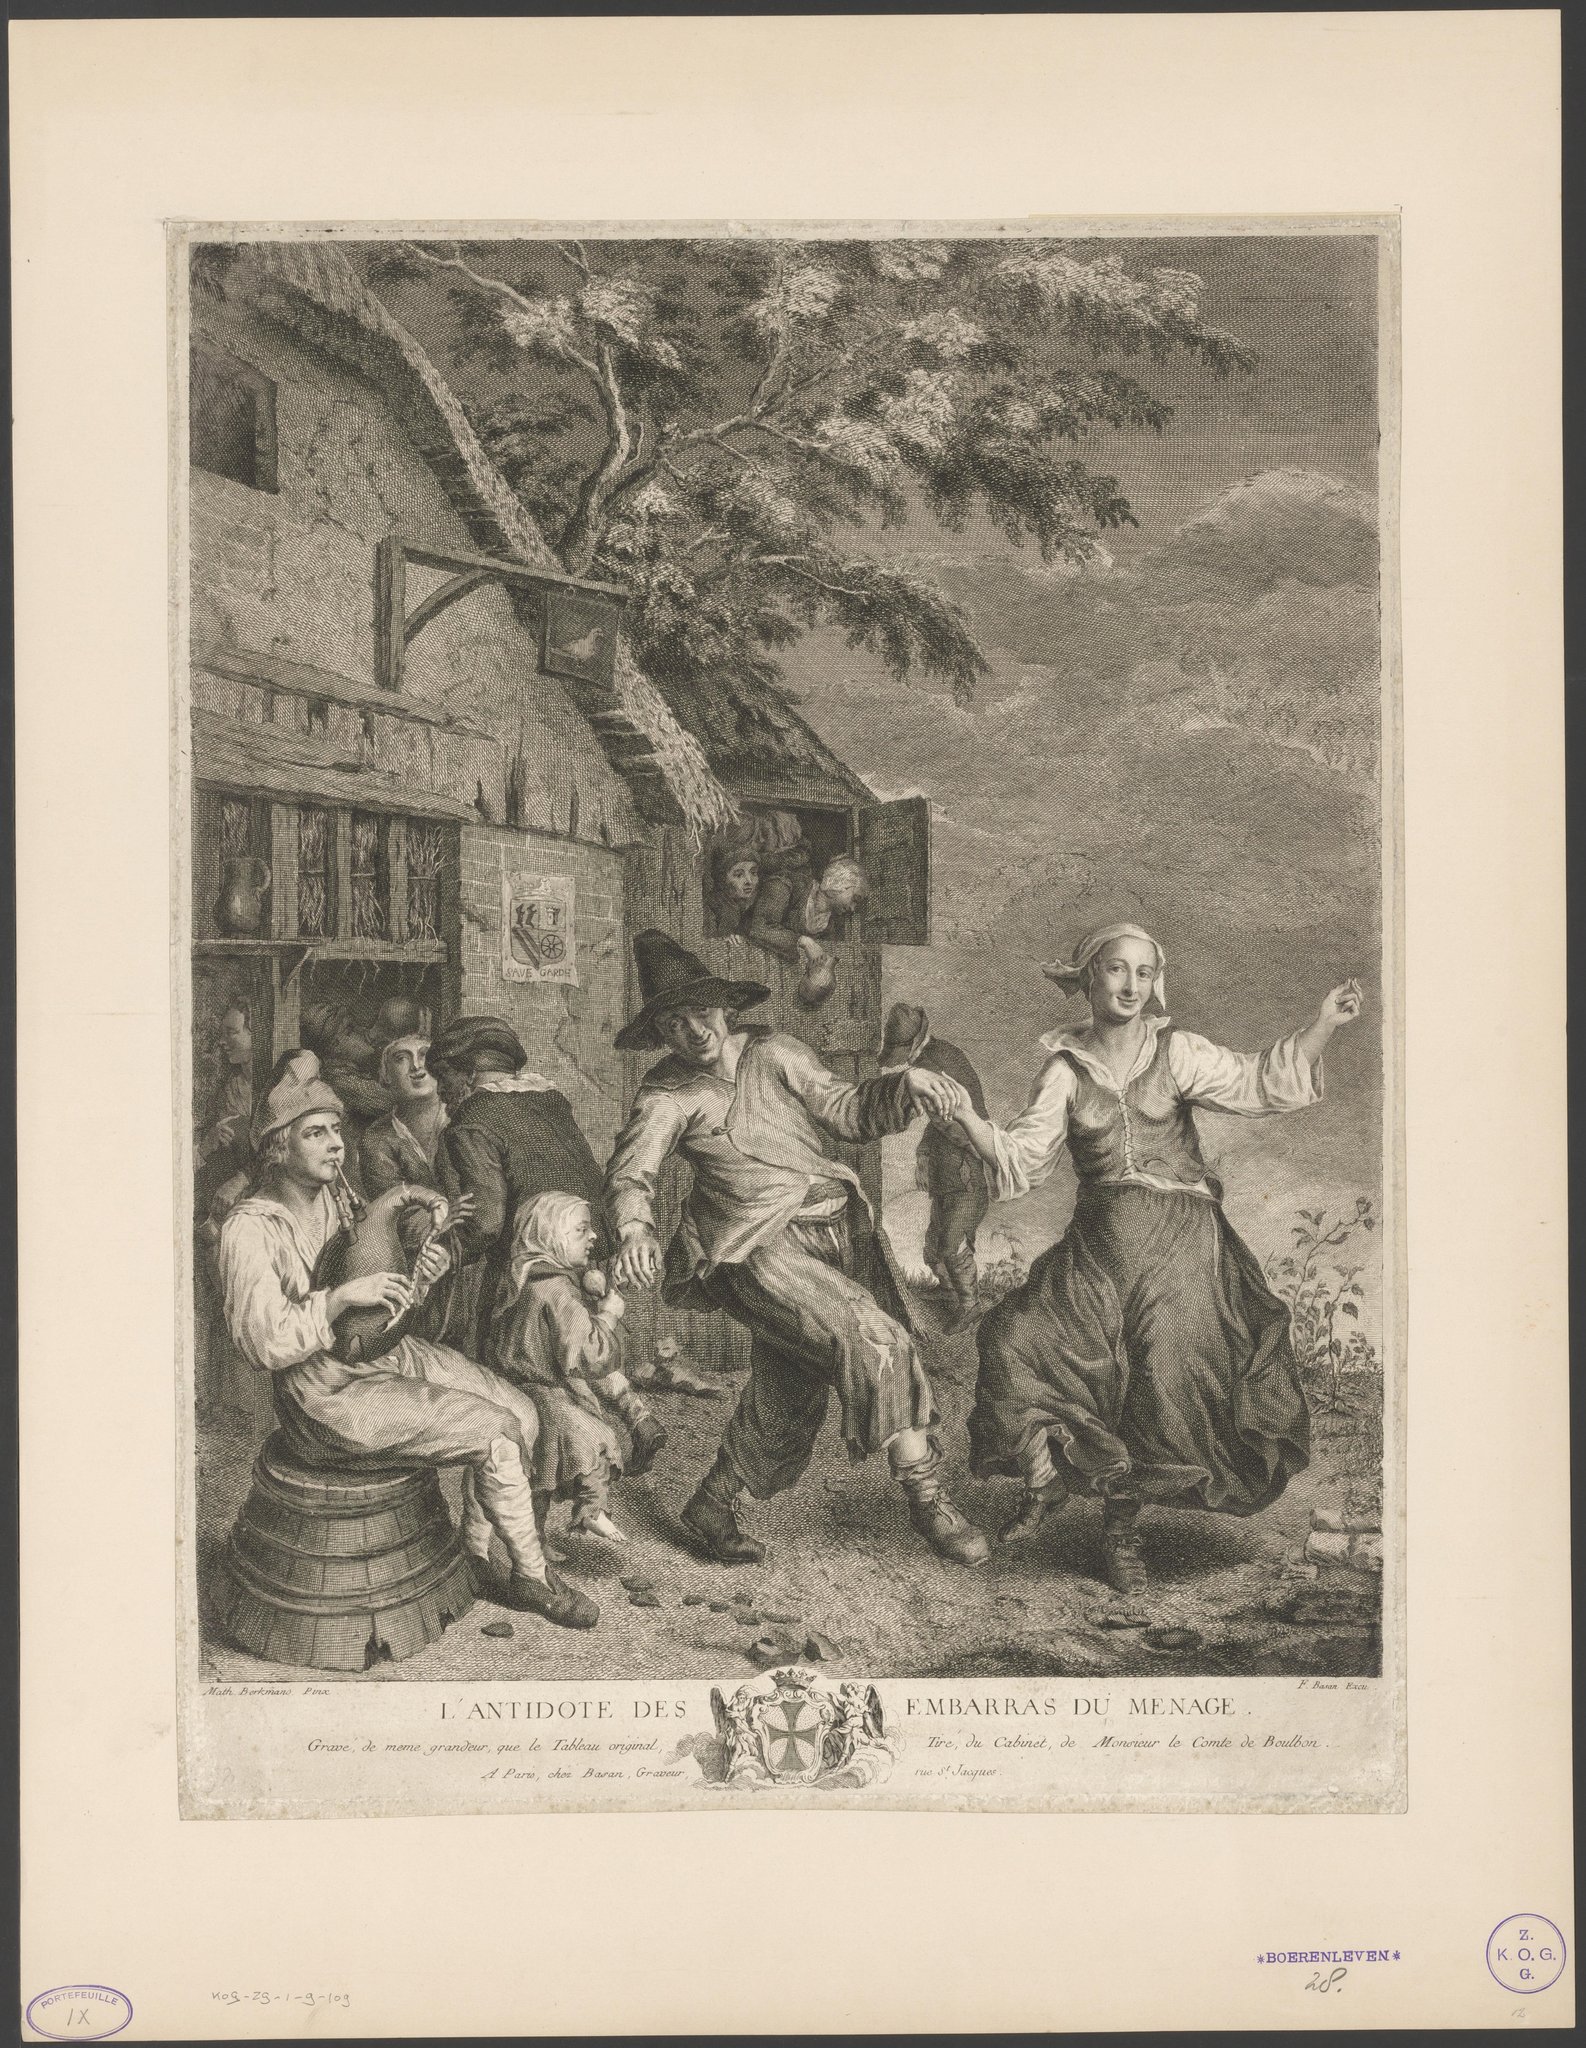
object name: print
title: L'Antidote des embarras du menage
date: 1733-1797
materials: paper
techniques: engraving, etching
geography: paris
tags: one pair dancing; man and woman dancing as a couple, hotel, hostelry, inn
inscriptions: stamp, stamp, collector's mark: Lugt 1641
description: Onderwerpsrubrieken binnen de Atlas Zeden en Gewoonten: Handel, nijverheid en verkeer, Boerenleven.